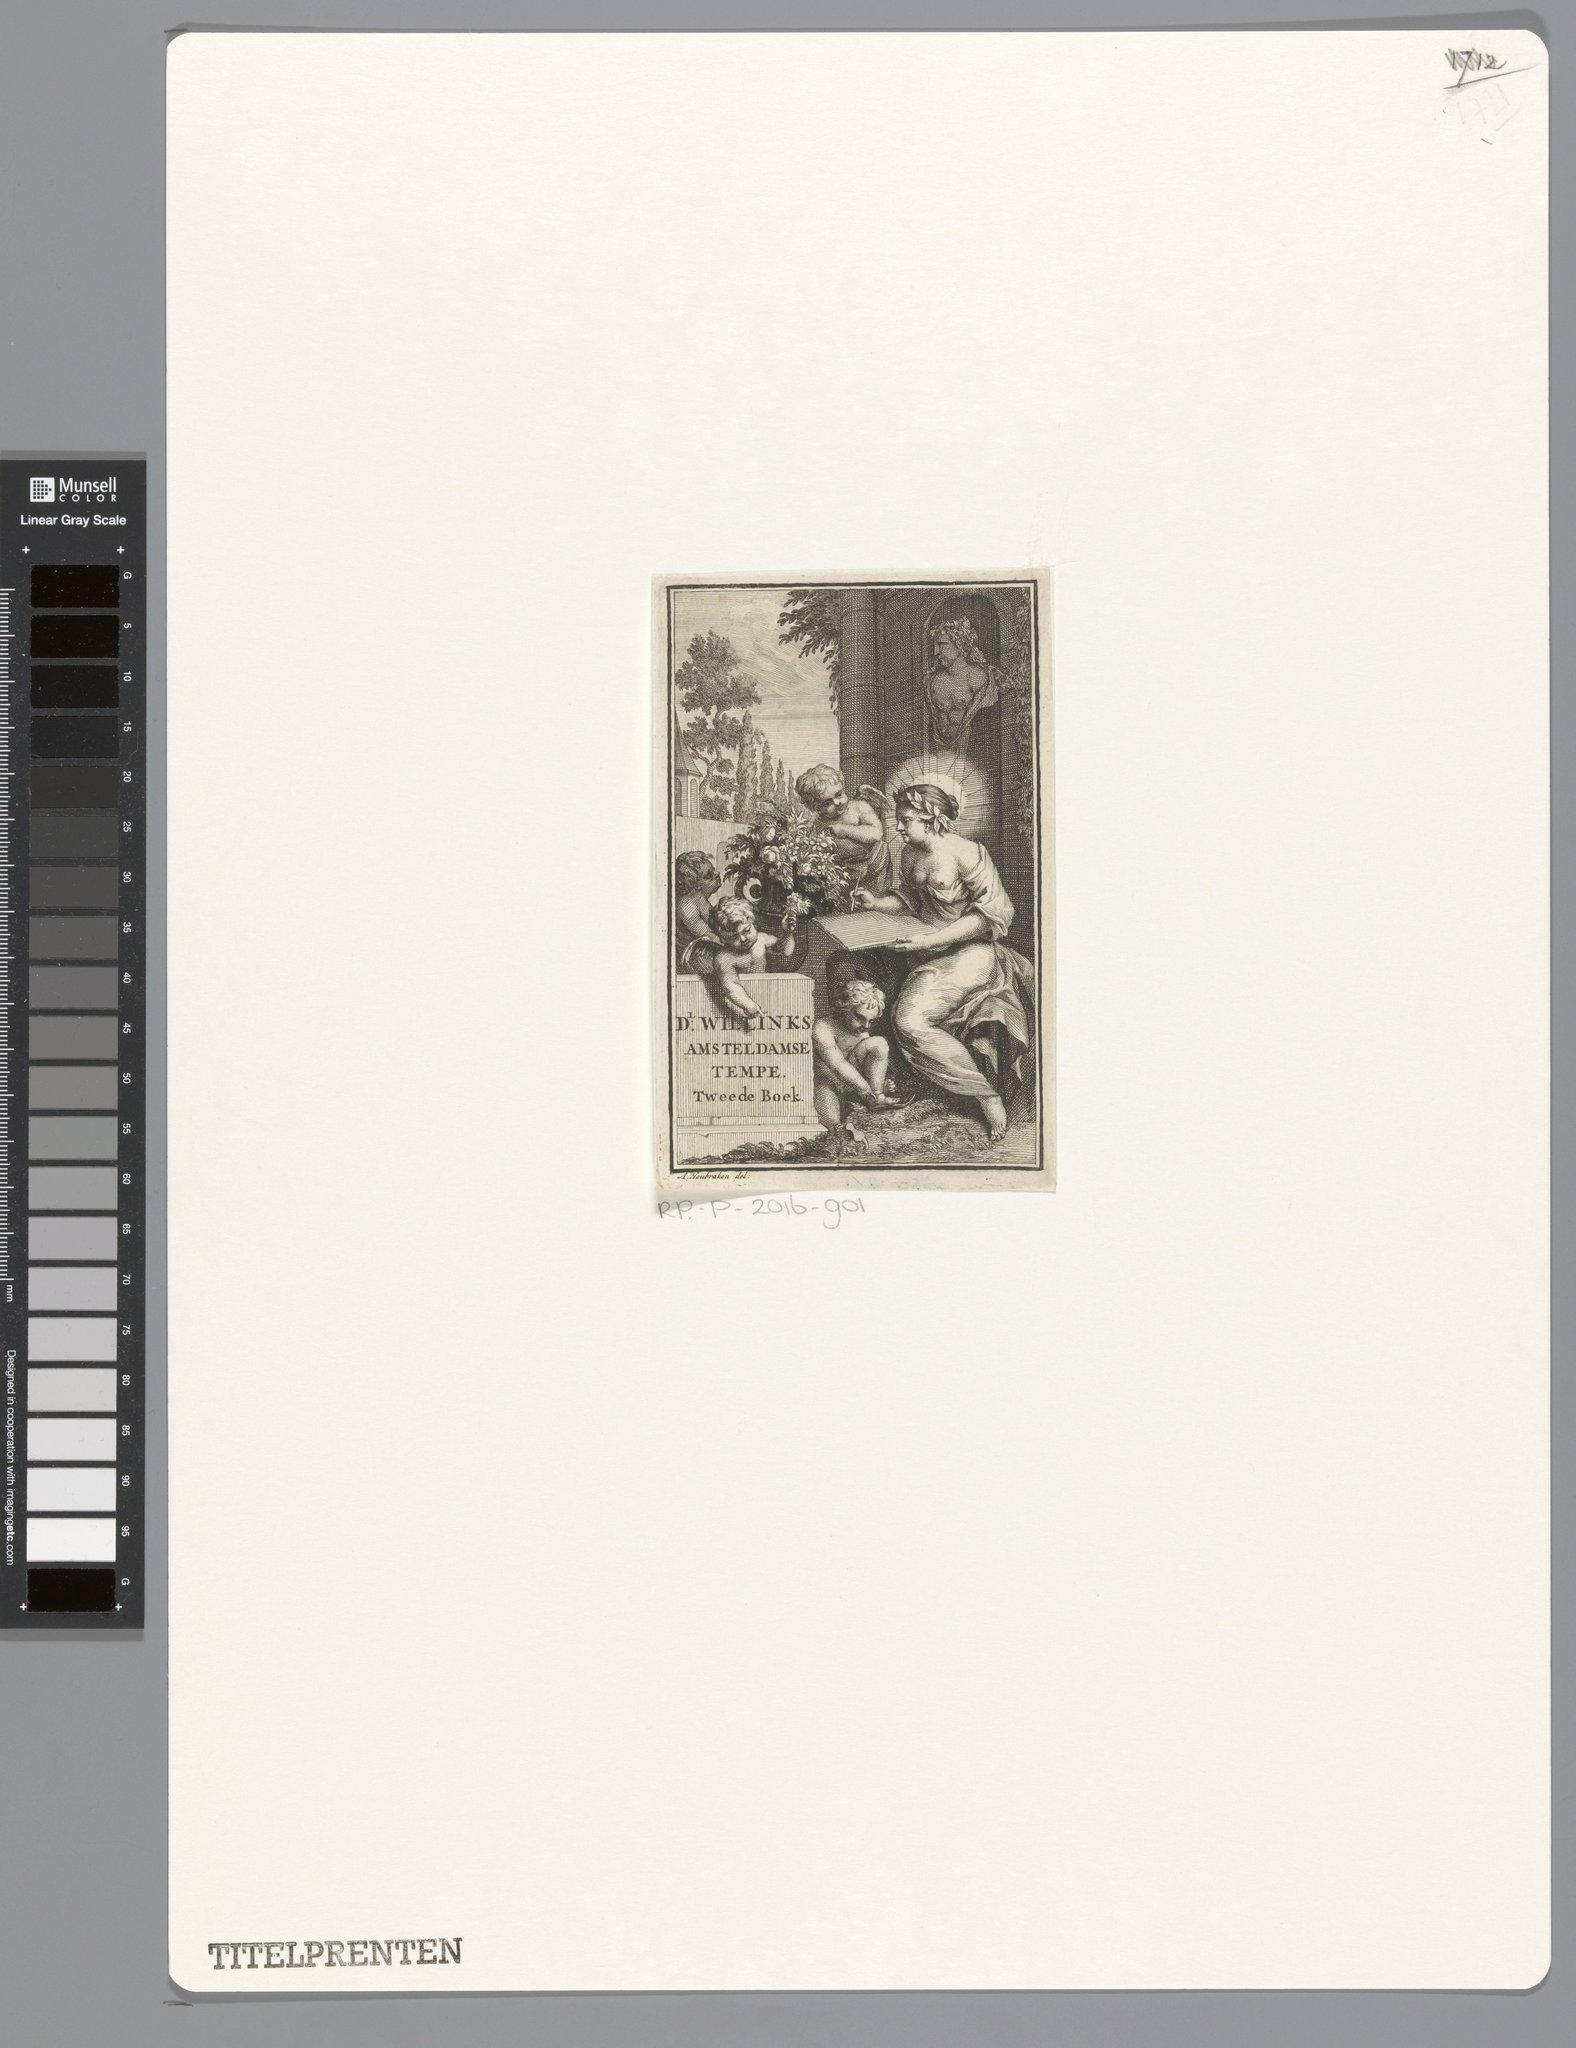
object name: print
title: Poëzie bestudeert vaas met bloemen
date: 1712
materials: paper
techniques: engraving, etching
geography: amsterdam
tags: year divided into four seasons, symbolic representations, allegories and emblems ~ poetry; 'poesia' (ripa), flowers in a vase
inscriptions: collector's mark: Lugt 2228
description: Prent uit: Willink, Daniël. Amsterdamsche tempe of de nieuwe plantagie Begrepen in twee boeken. Nevens den amstelstroom. Gaete, Hendrik van de, 1712. Prent afkomstig uit een plakalbum met titelprenten, ornamenten etc. op blauw papier in 1983 uit elkaar gehaald. Volgens een notitie op verso zat de prent op p. 115 van dit album.